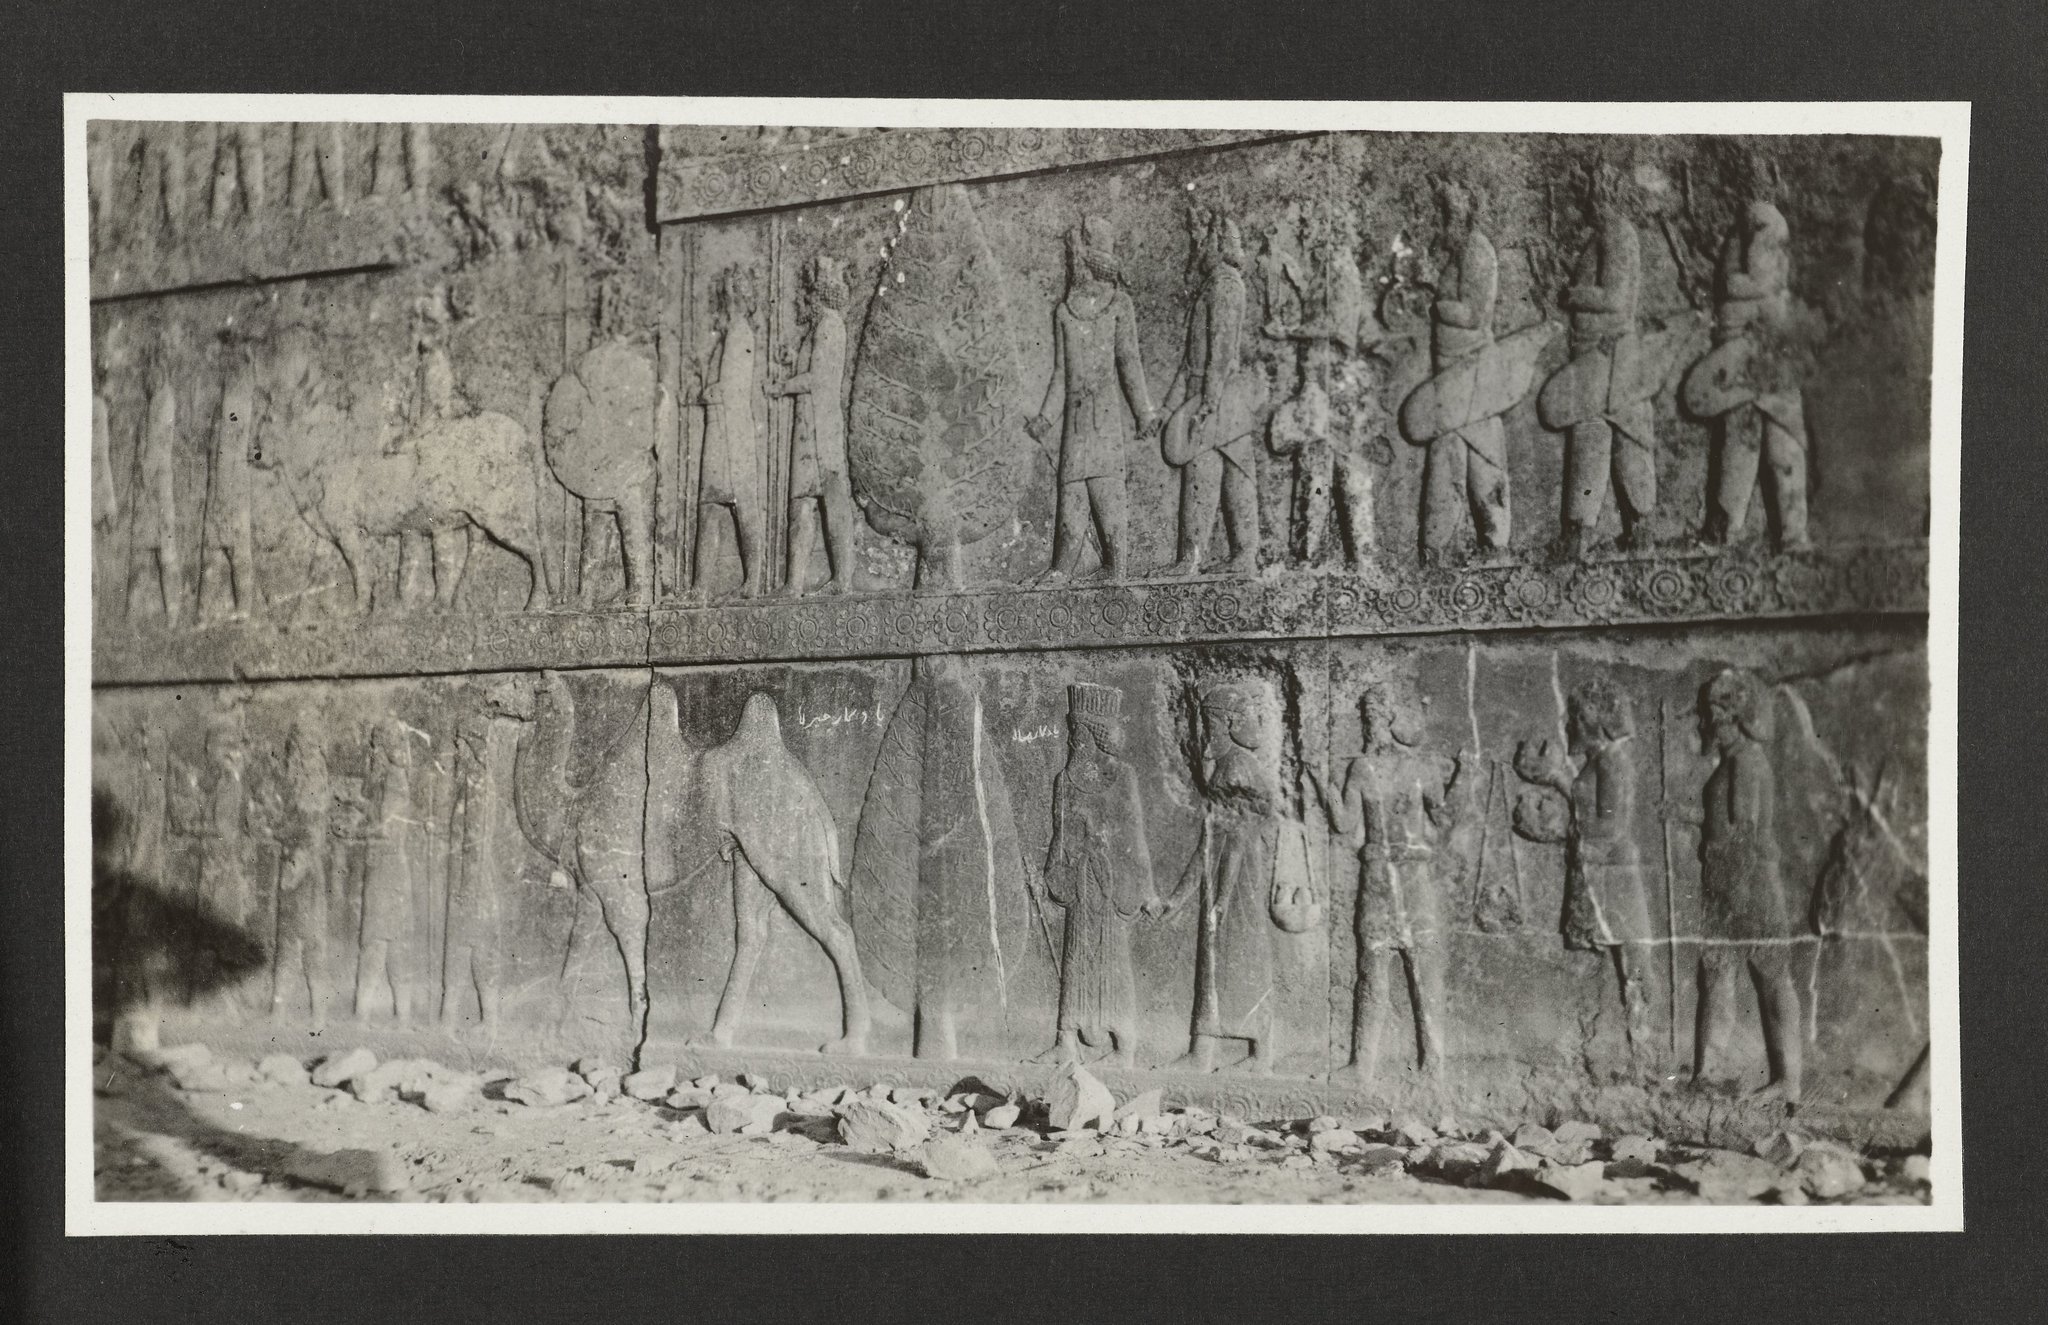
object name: photograph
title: Detail van het bas-relief, ter zyde van de trap voerende naar de ruines van het paleis van Darius. Het fries stelt een optocht voor van schatting brengende vertegenwoordigers van de tot het Perzische Ryk behoorende landen. De paleizen te Persepolis vormden het zomerverblyf der Perzische Vorsten uit het Achaemeniden geslacht, Darius, Xerxes, enz..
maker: a.g.a. van eelde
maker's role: engineer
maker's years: 1862-1950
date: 1925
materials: cardboard, paper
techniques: gelatin silver print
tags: iran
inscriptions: number: ‘18.’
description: Titel op object afkomstig uit inventaris (Verklaring der Photo's) behorend bij het album.